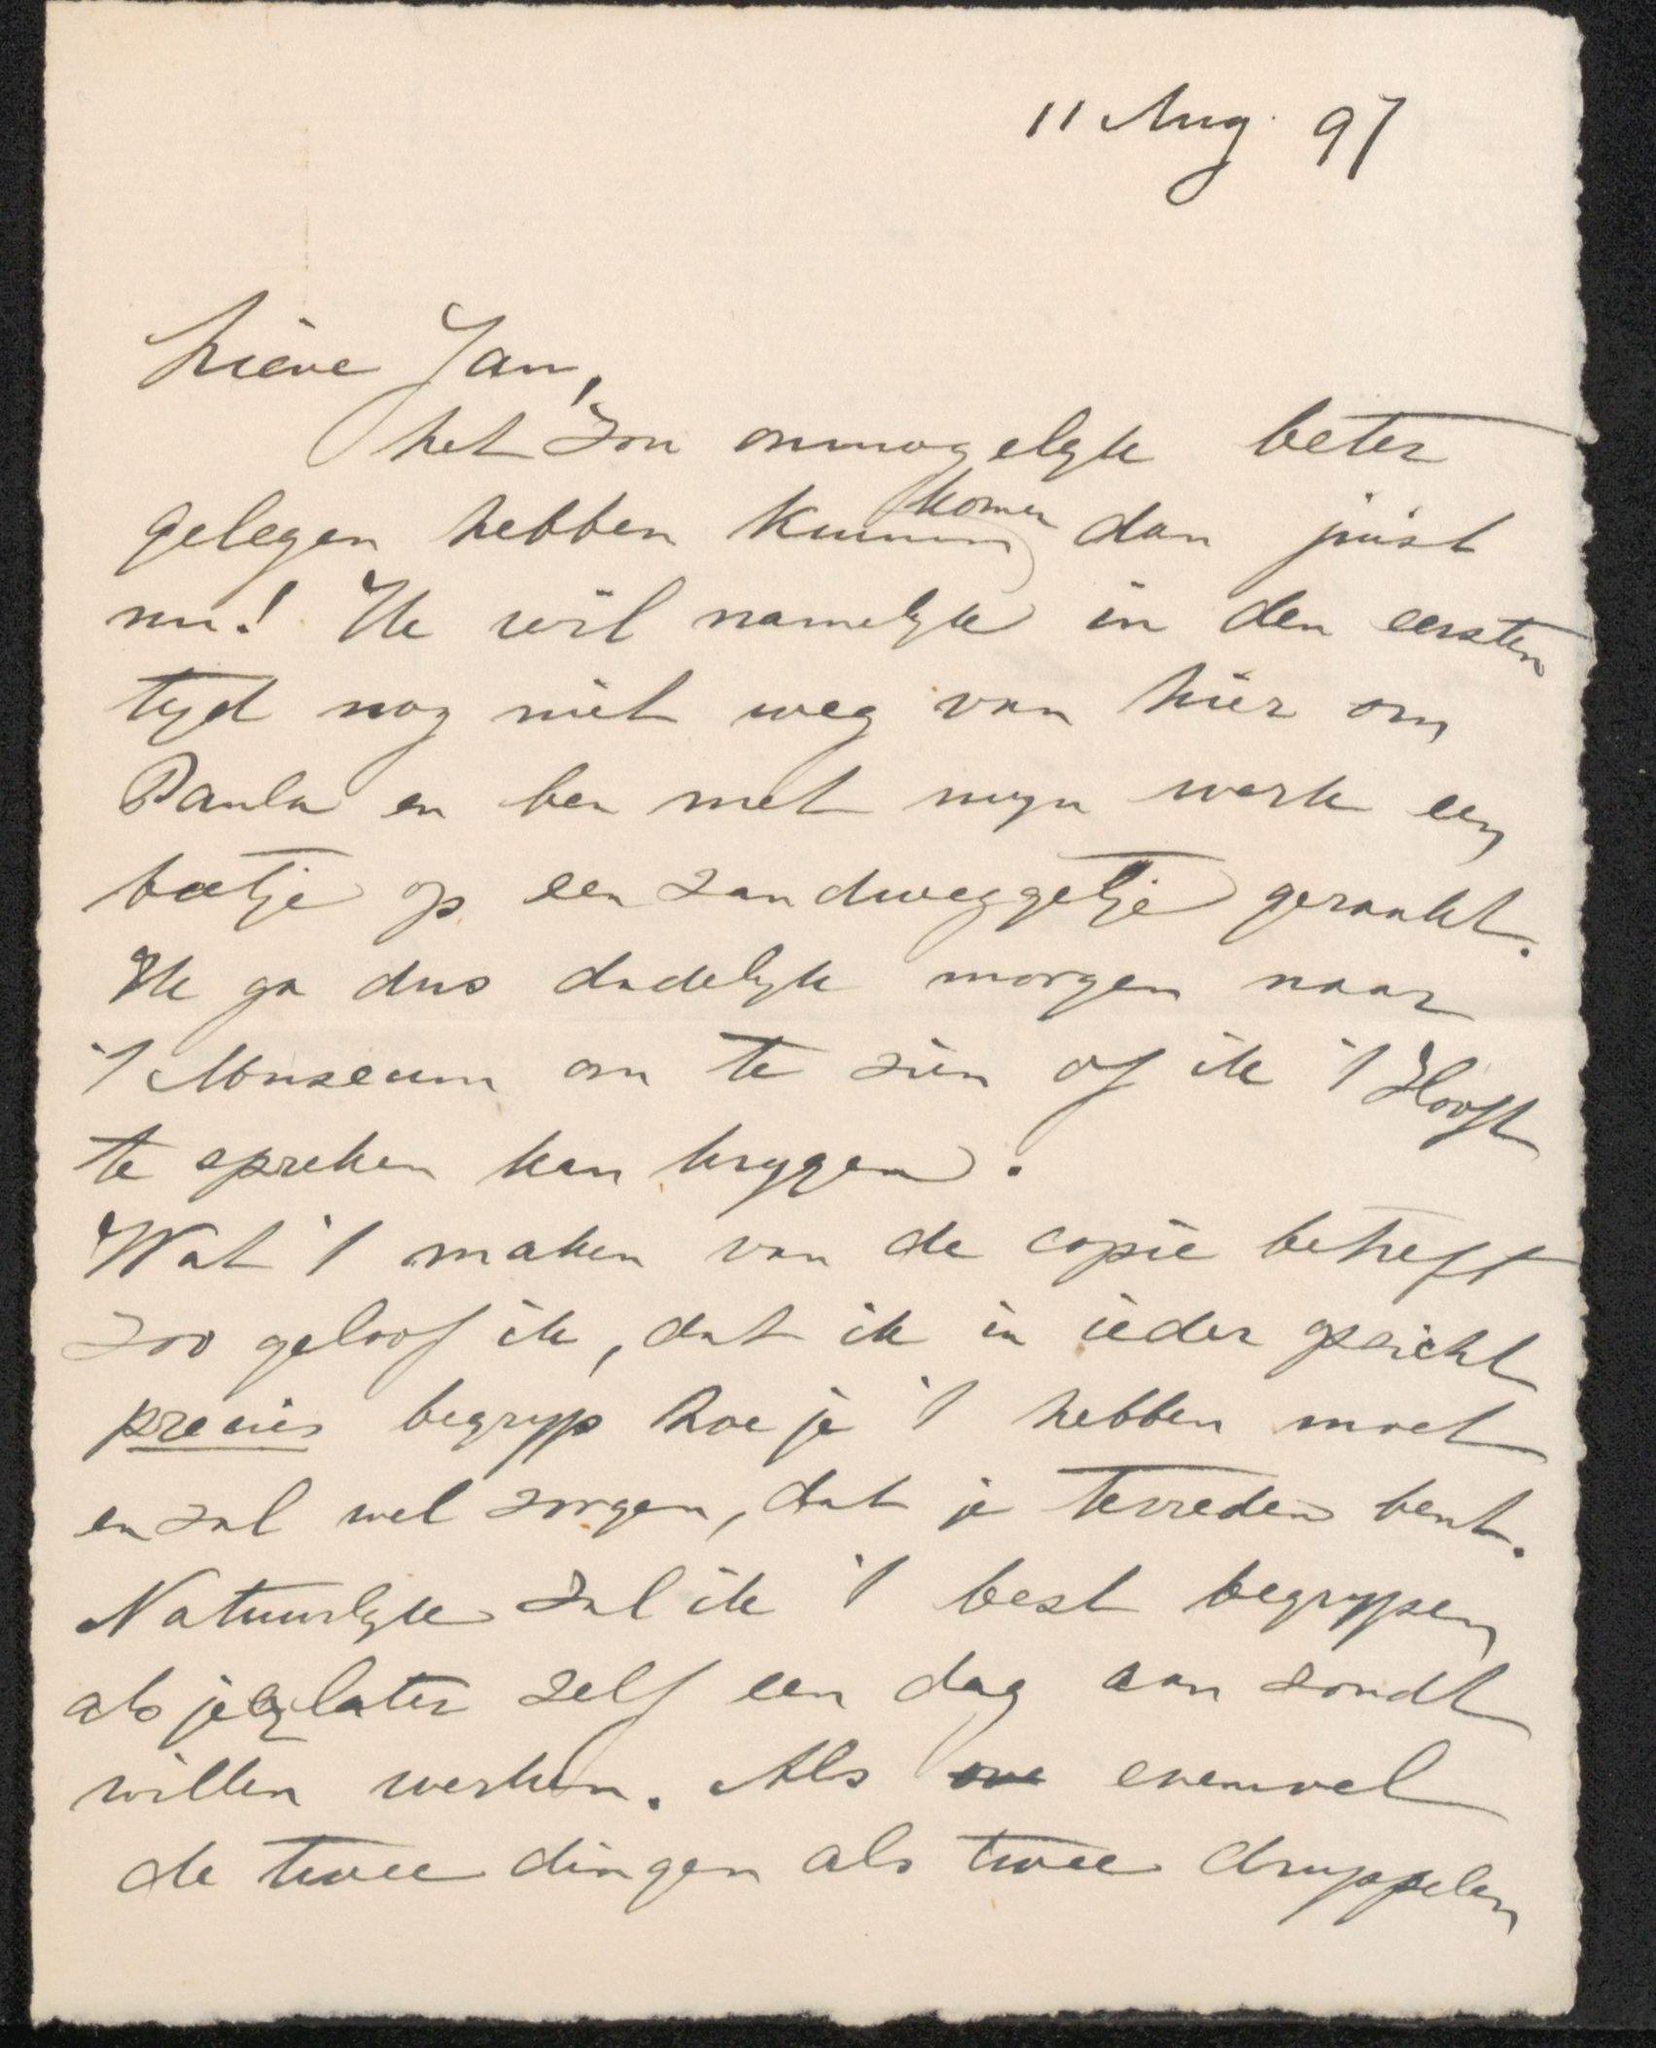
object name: letter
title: Brief aan Jan Veth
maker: wally moes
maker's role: draughtsman, print maker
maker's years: 1856-1918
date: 1874-1918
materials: ink, paper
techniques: pen, writing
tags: dordrecht, painter, designer, jan veth, painting (including book-illumination, miniature-painting)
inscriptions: collector's mark: ‘RPK’